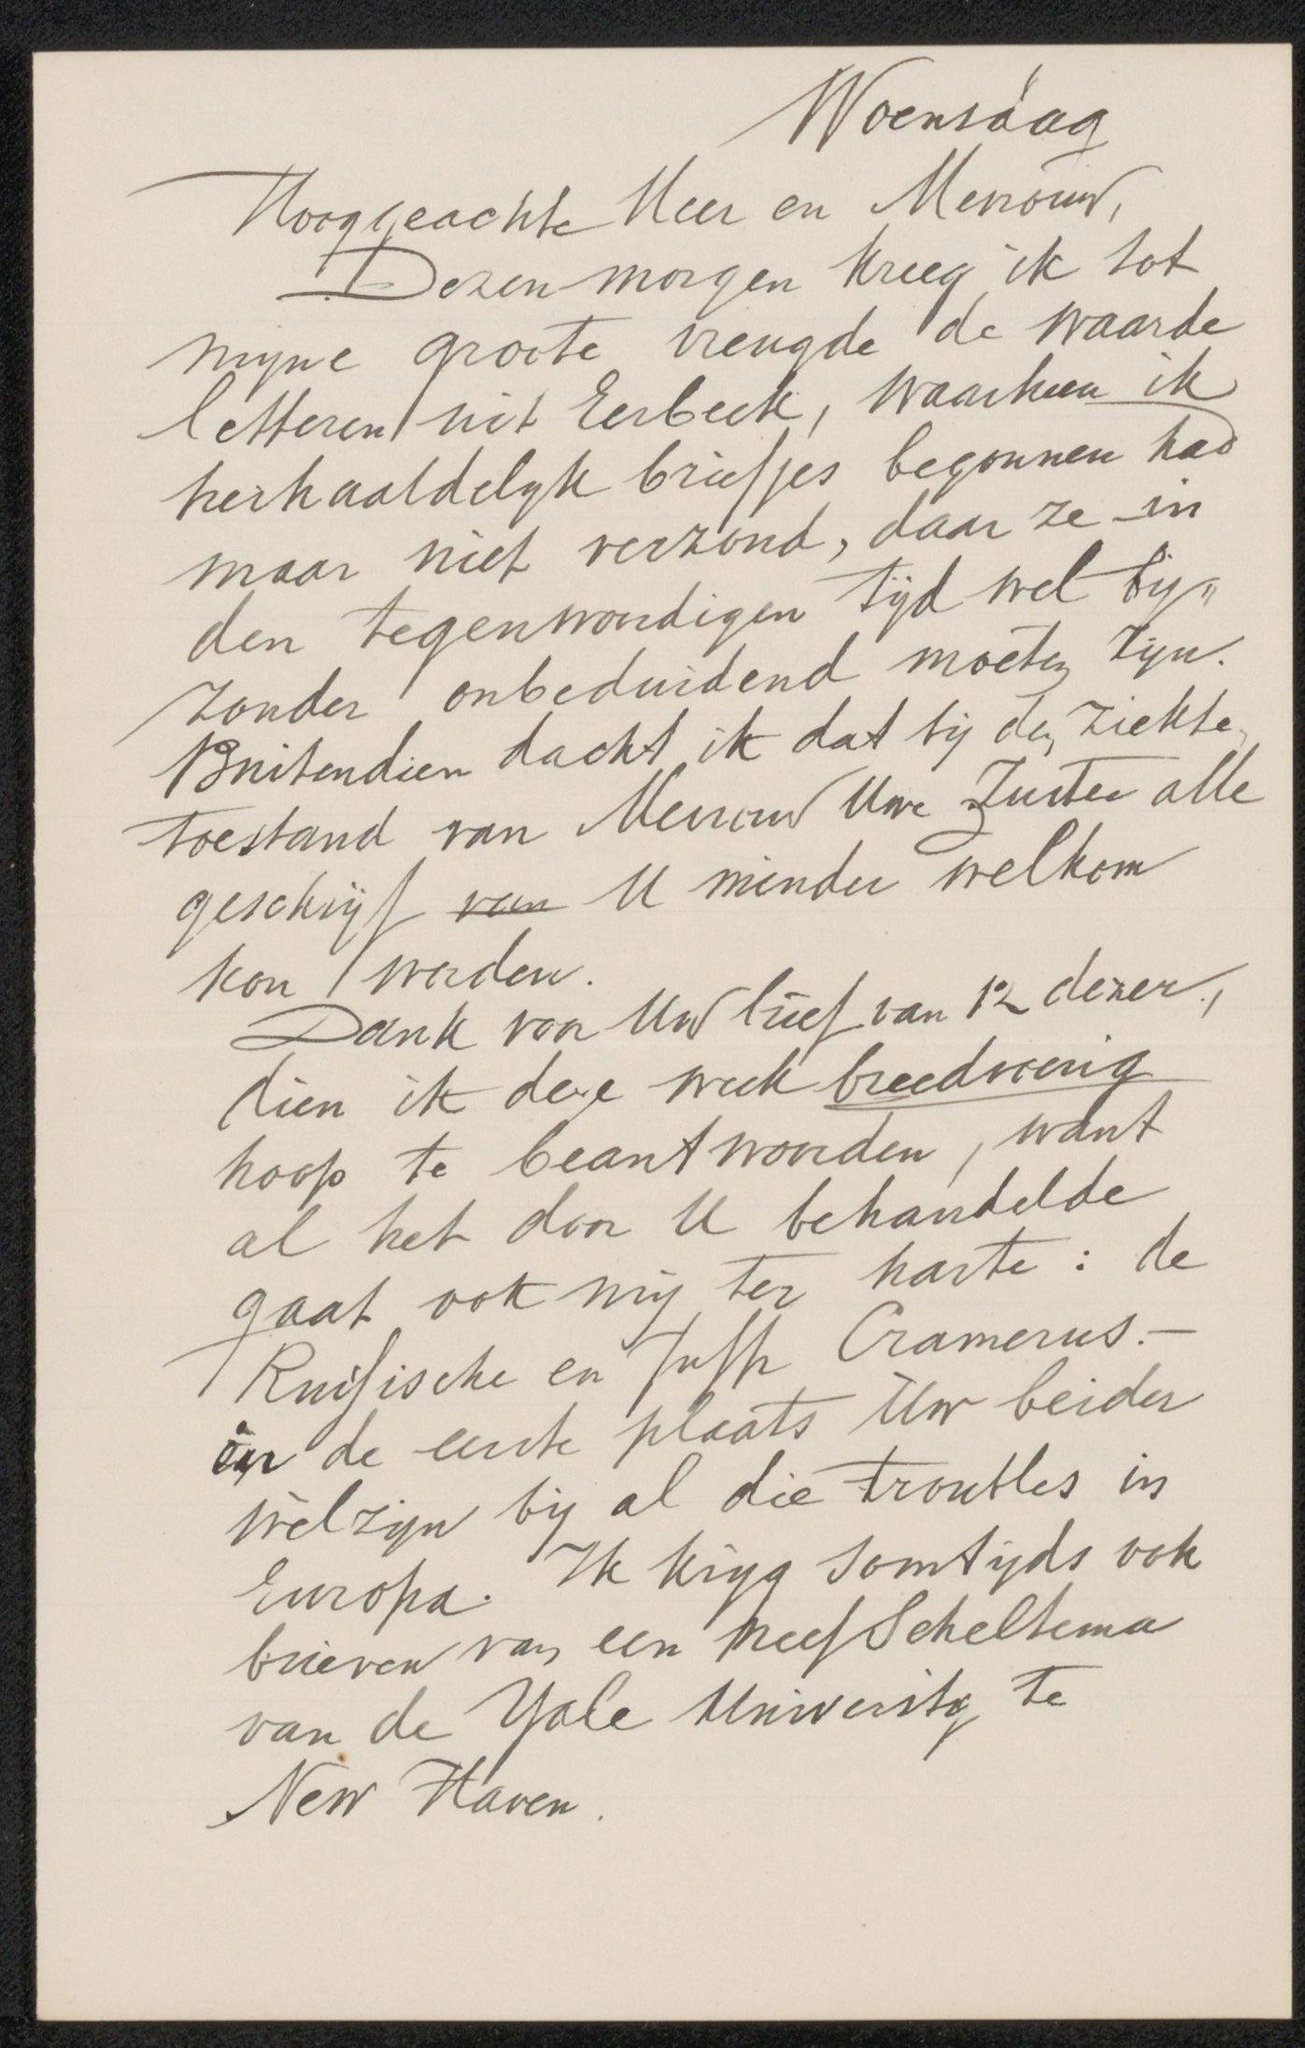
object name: letter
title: Brief aan Max Wilhelm Carl Weber en Anne Antoinette Weber-Van Bosse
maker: august allebé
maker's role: draughtsman, print maker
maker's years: 1838-1927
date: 1862-1927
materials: ink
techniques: pen, writing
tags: batavia, anne antoinette weber-van bosse, drawing, diseases, historical persons (portraits and scenes from the life)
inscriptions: watermark